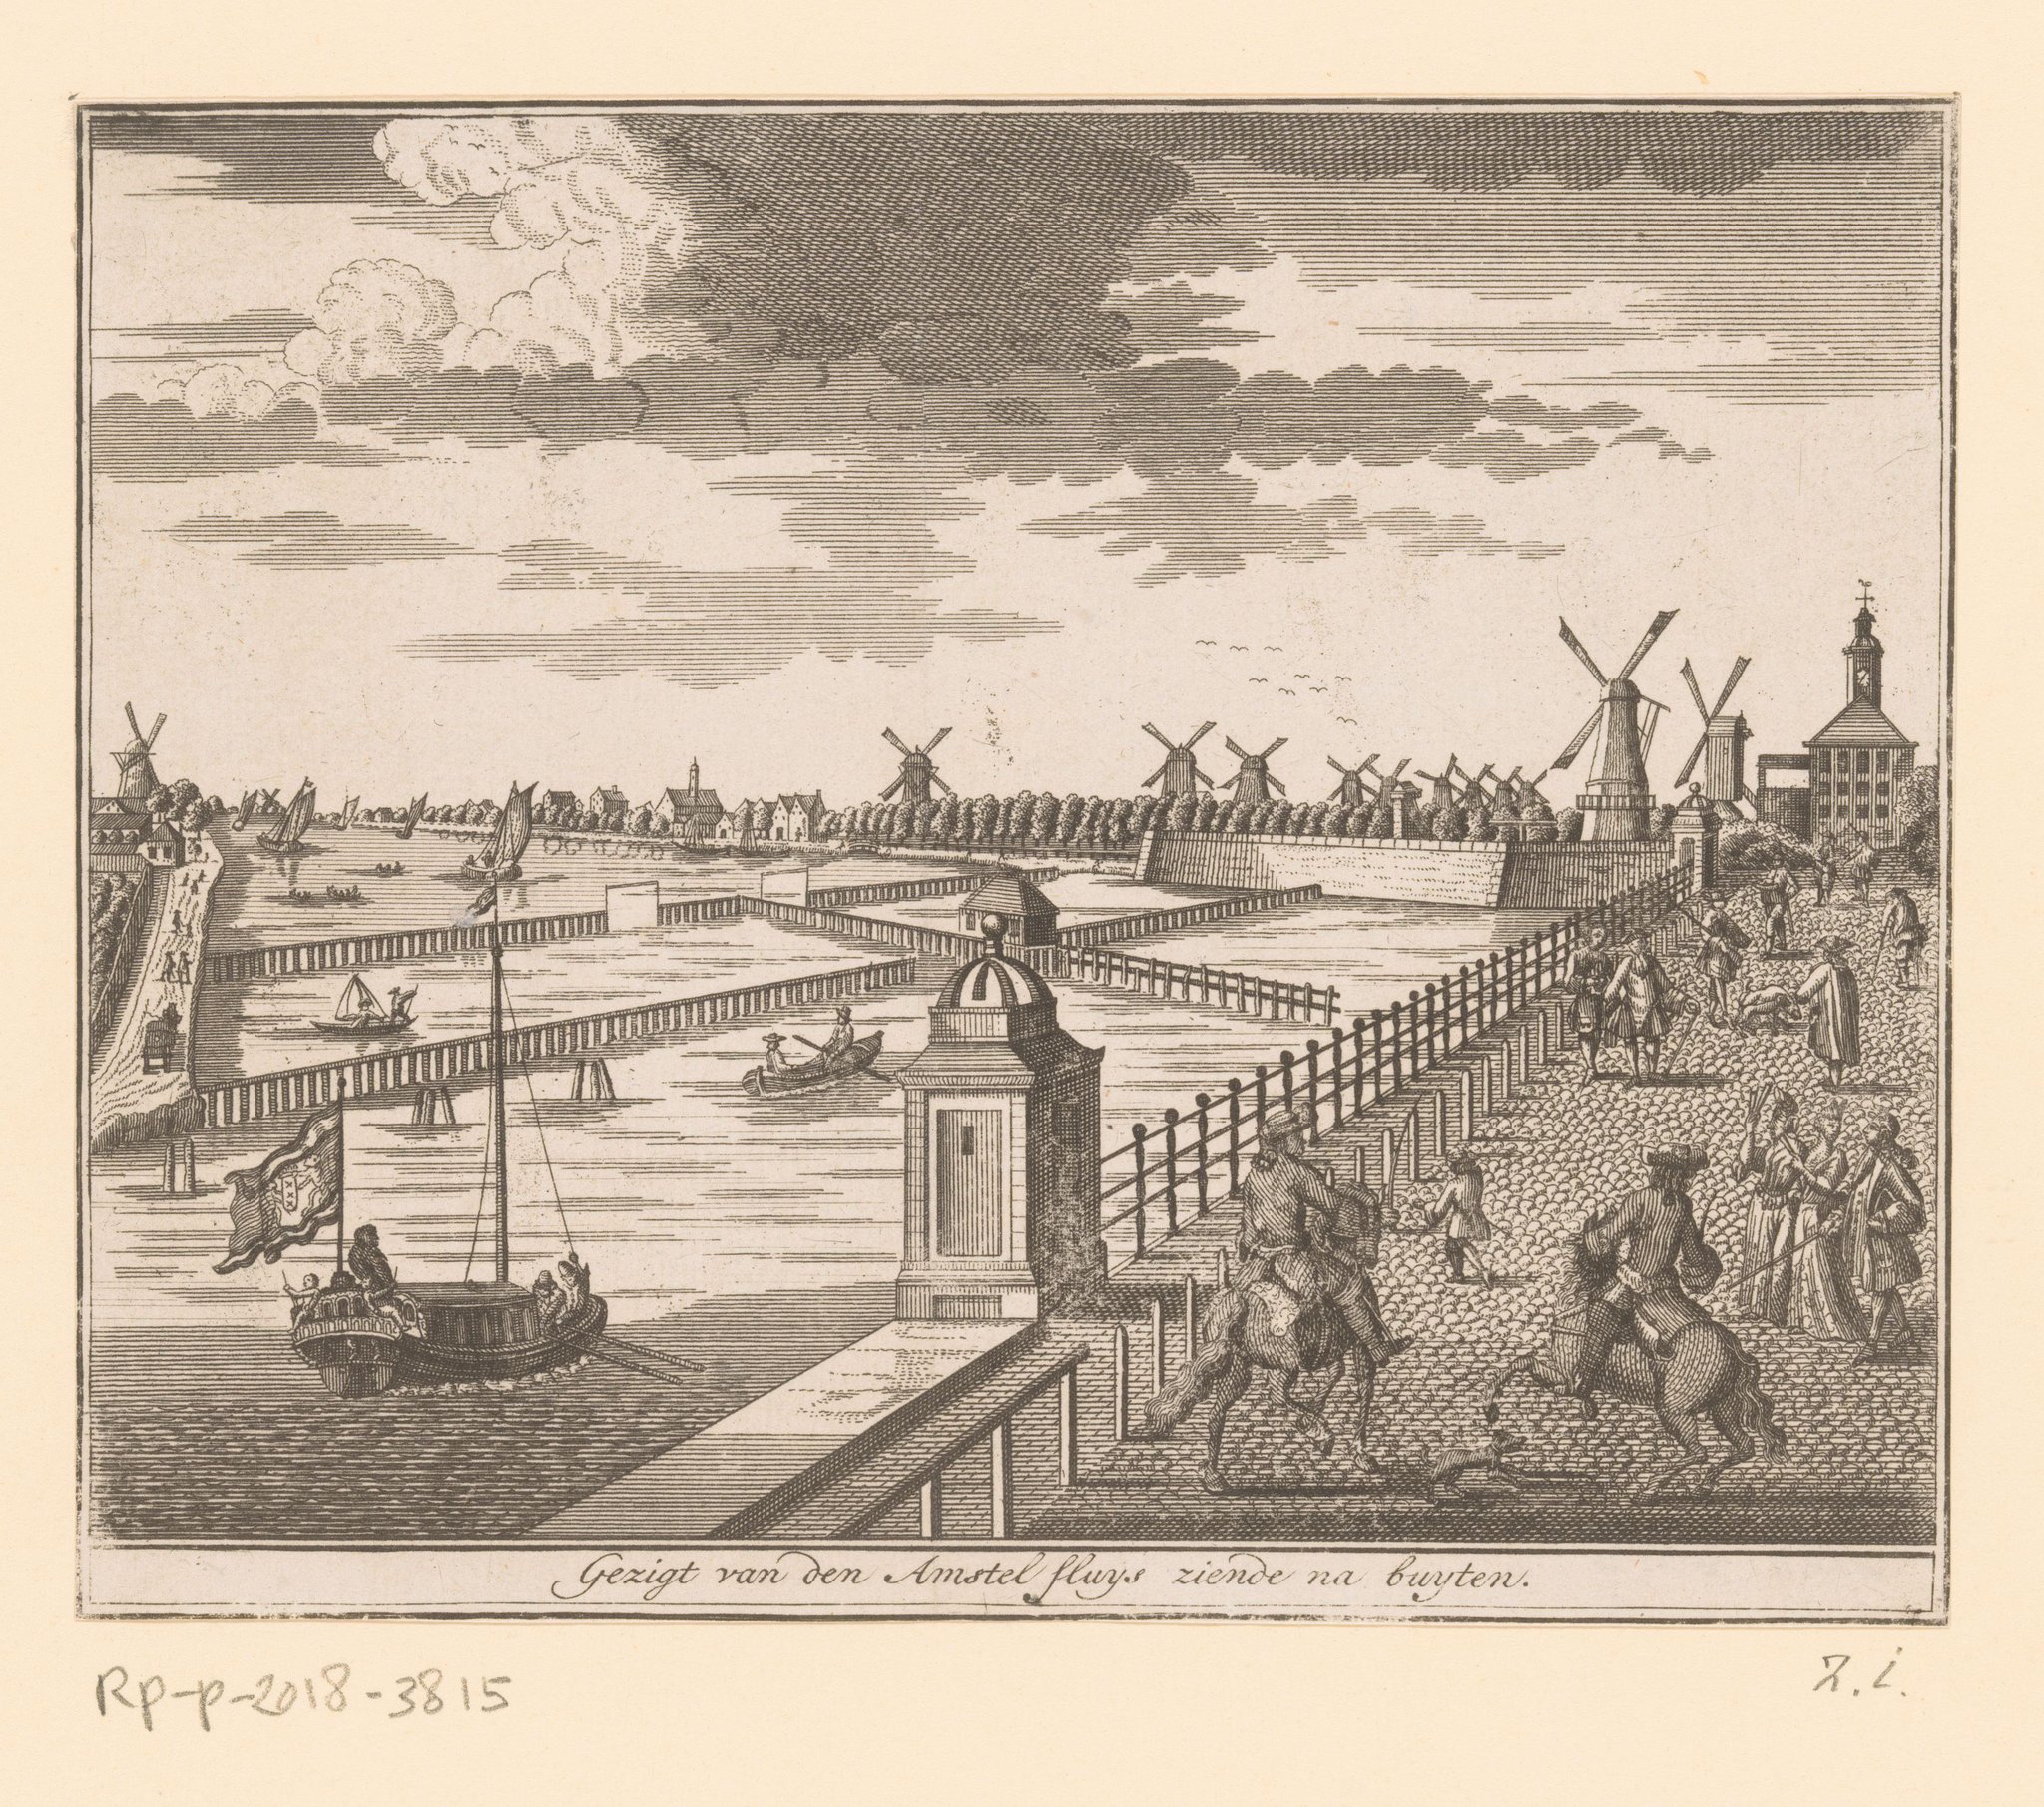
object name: print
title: Gezigt van den Amstel-sluys ziende na buyten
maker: Anonymous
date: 1685-1748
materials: paper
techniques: etching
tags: canals, waters (in city), bridge in city across river, canal, etc., windmill